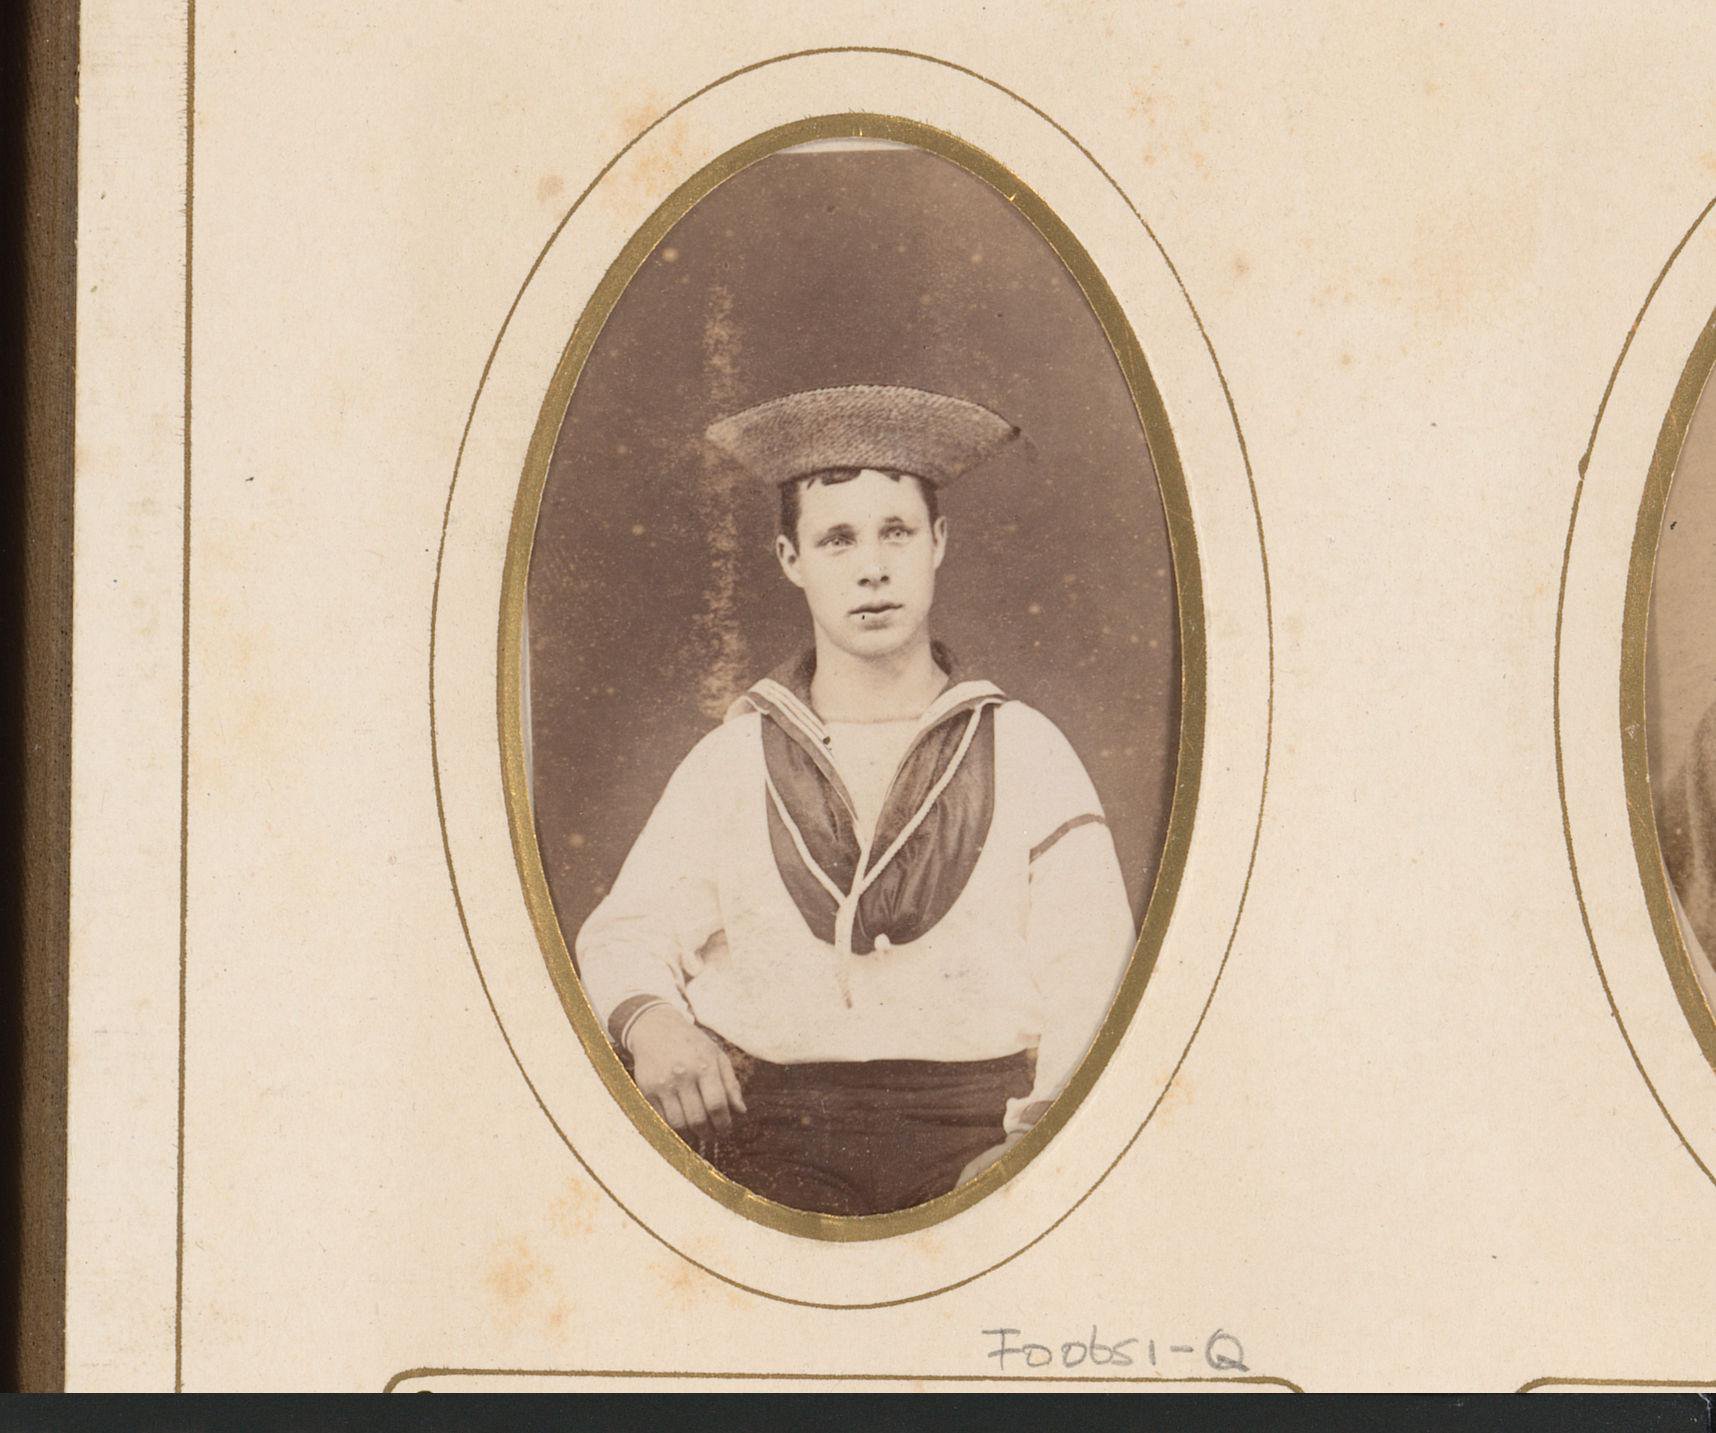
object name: album leaf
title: Portret van een matroos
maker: saverio ciantar preziosi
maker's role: fotograaf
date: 1880-1915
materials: cardboard, photographic support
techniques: albumen print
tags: adult man, historical persons, seaman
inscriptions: inscription: ‘133 Strada Teatro, St. George Palace Square, Valletta’